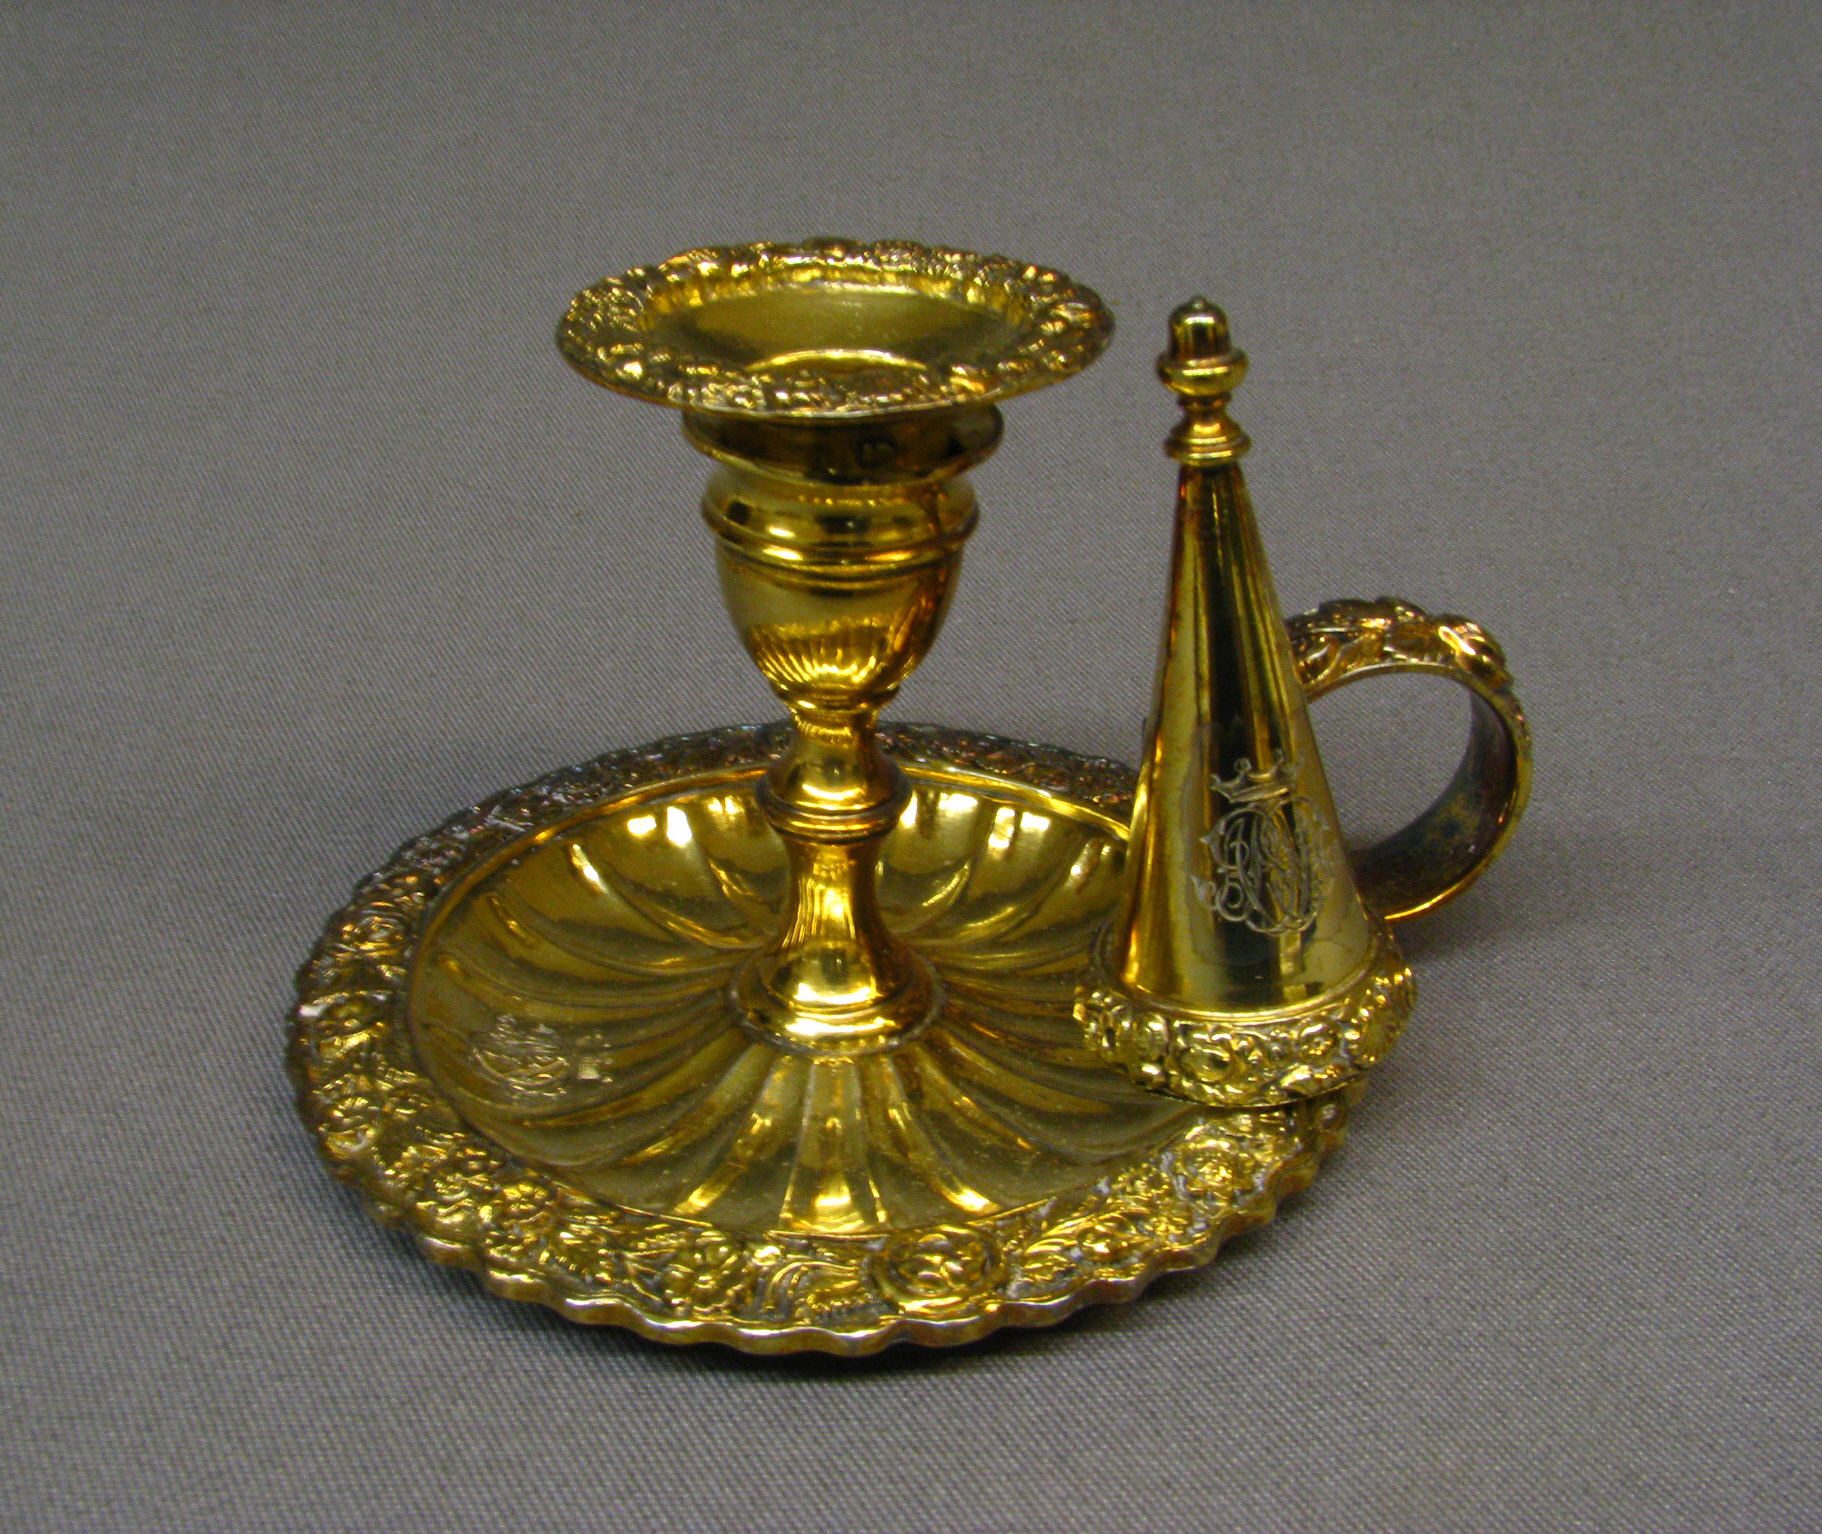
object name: chamber candlestick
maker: robert hennell ii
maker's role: maker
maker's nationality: british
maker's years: 1763-1833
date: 1824-1825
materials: silver gilt